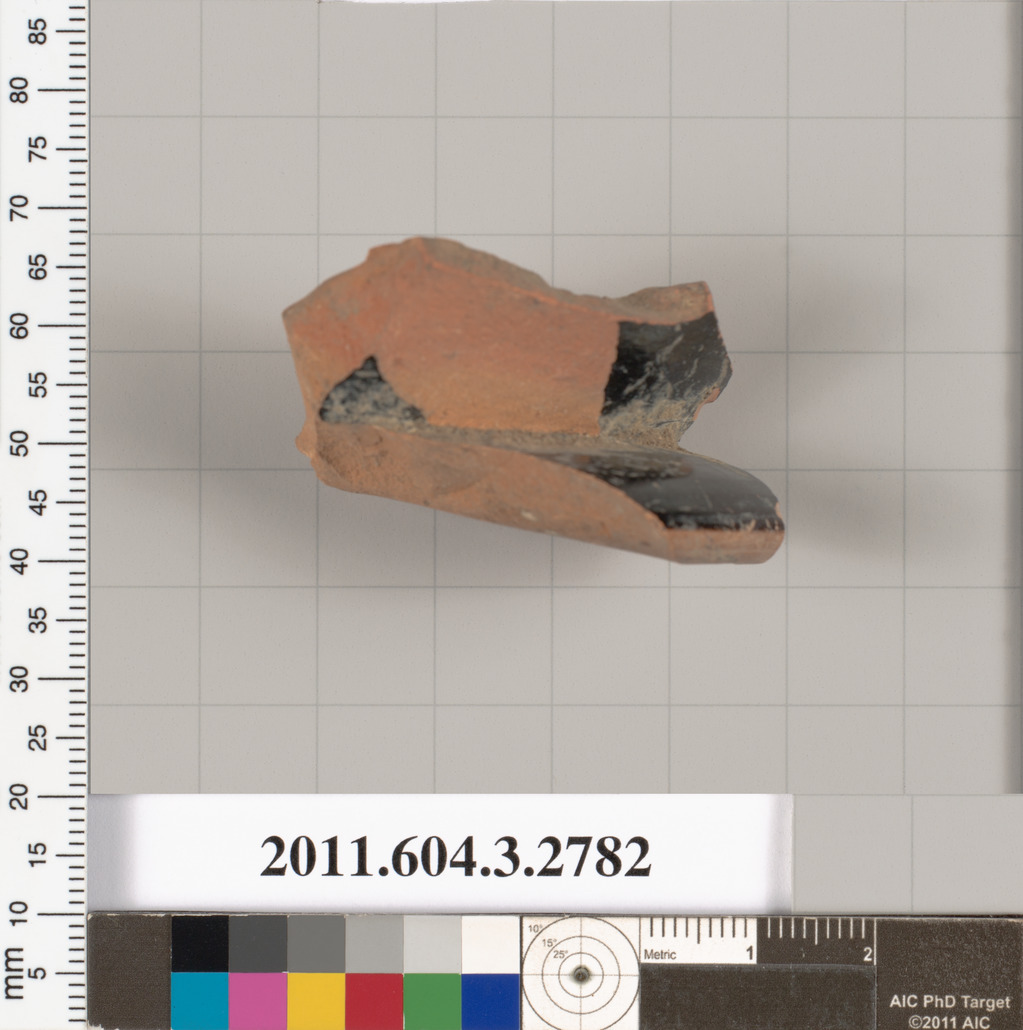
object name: olpe fragment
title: Terracotta fragment of an olpe (jug)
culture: greek, attic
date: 525-501 BCE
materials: terracotta